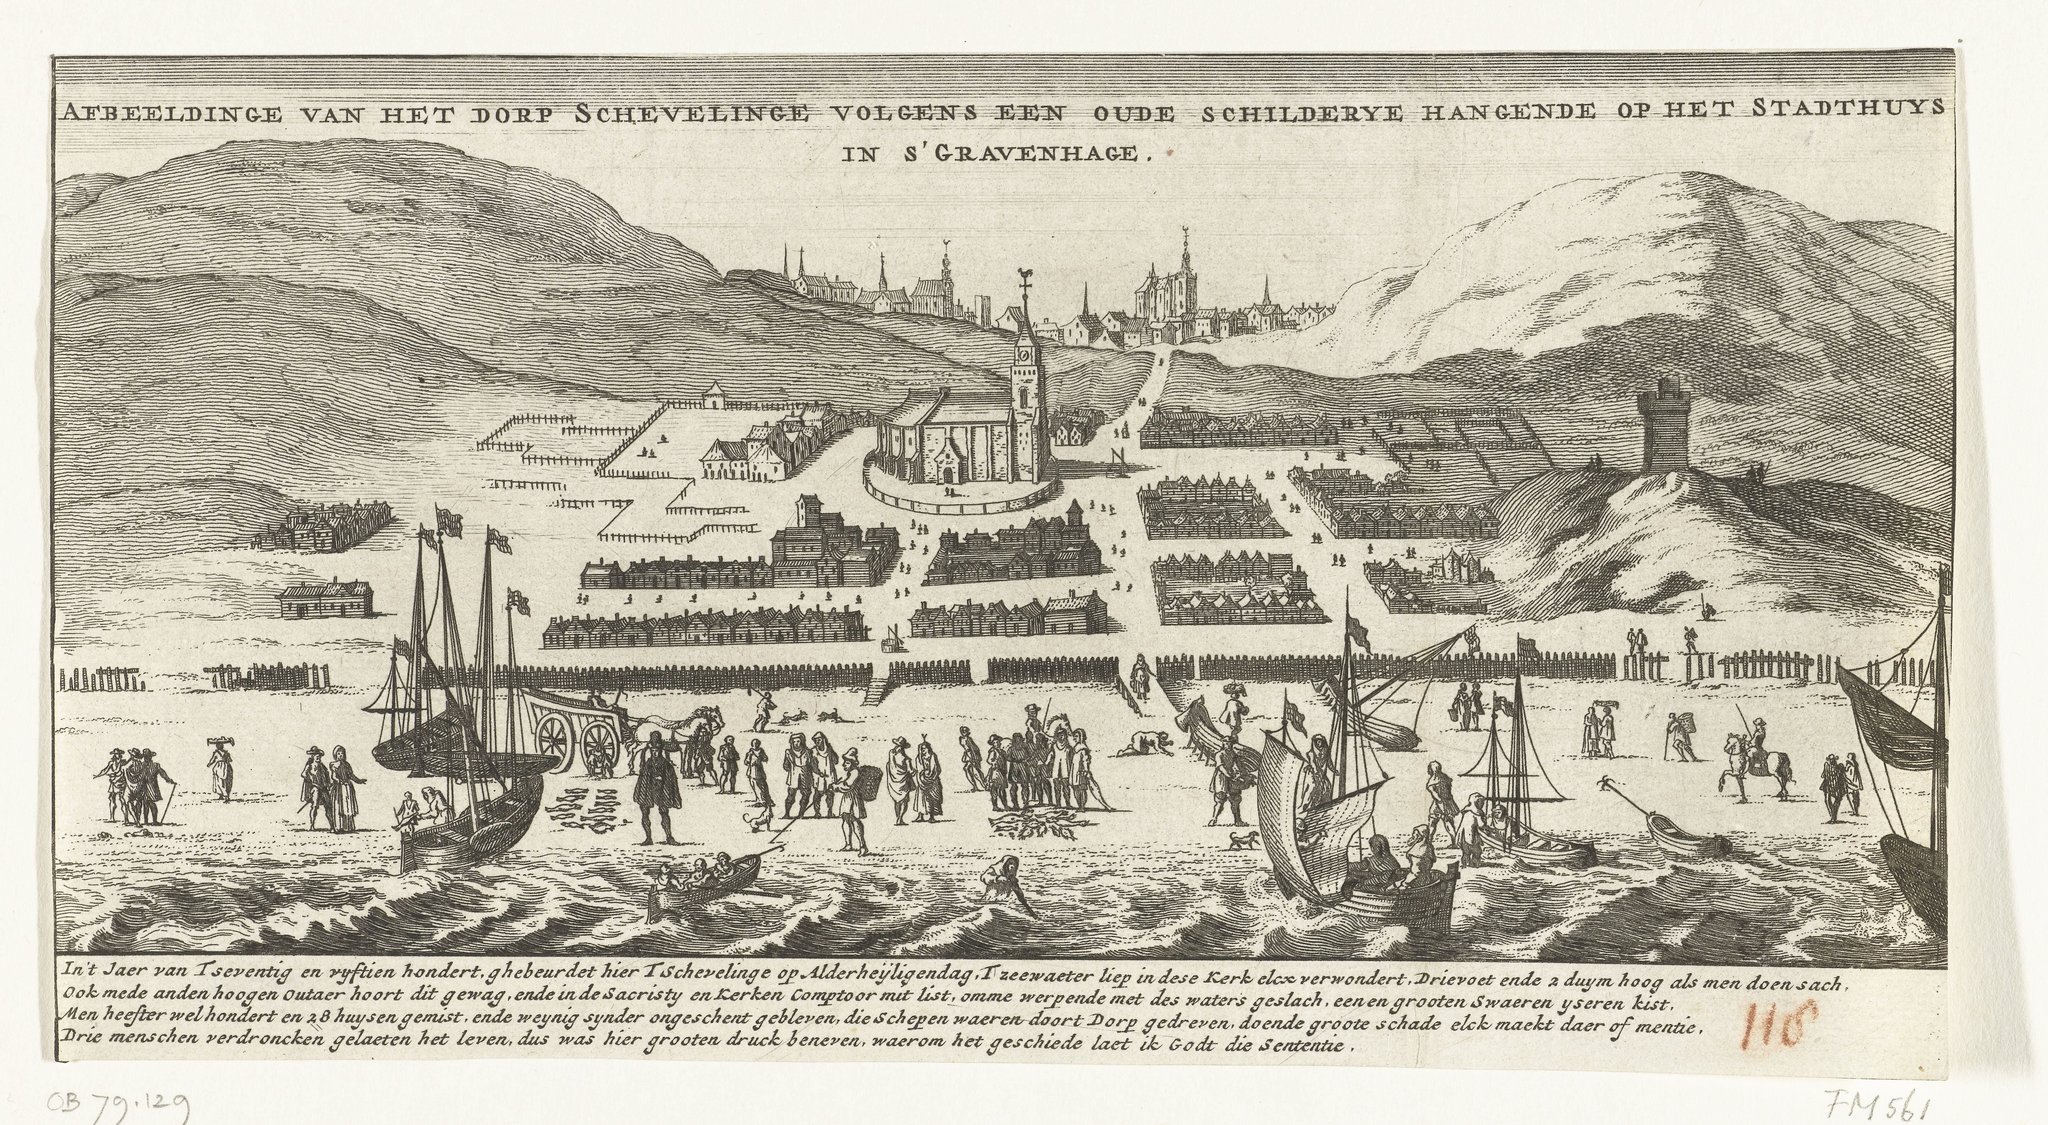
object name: history print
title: Afbeeldinge van het dorp Schevelinge volgens een oude schilderye hangende op het stadthuys in s'Gravenhage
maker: Anonymous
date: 1730-1799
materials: paper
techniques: etching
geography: netherlands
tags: flood, high tide, village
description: Gezicht op het dorp Scheveningen getroffen door een overstroming door een vloedgolf op Allerheiligen, 1 november 1570. Hierbij werden 128 huizen verwoest en verdronken 3 personen. Met onderschrift van 4 regels in het Nederlands.